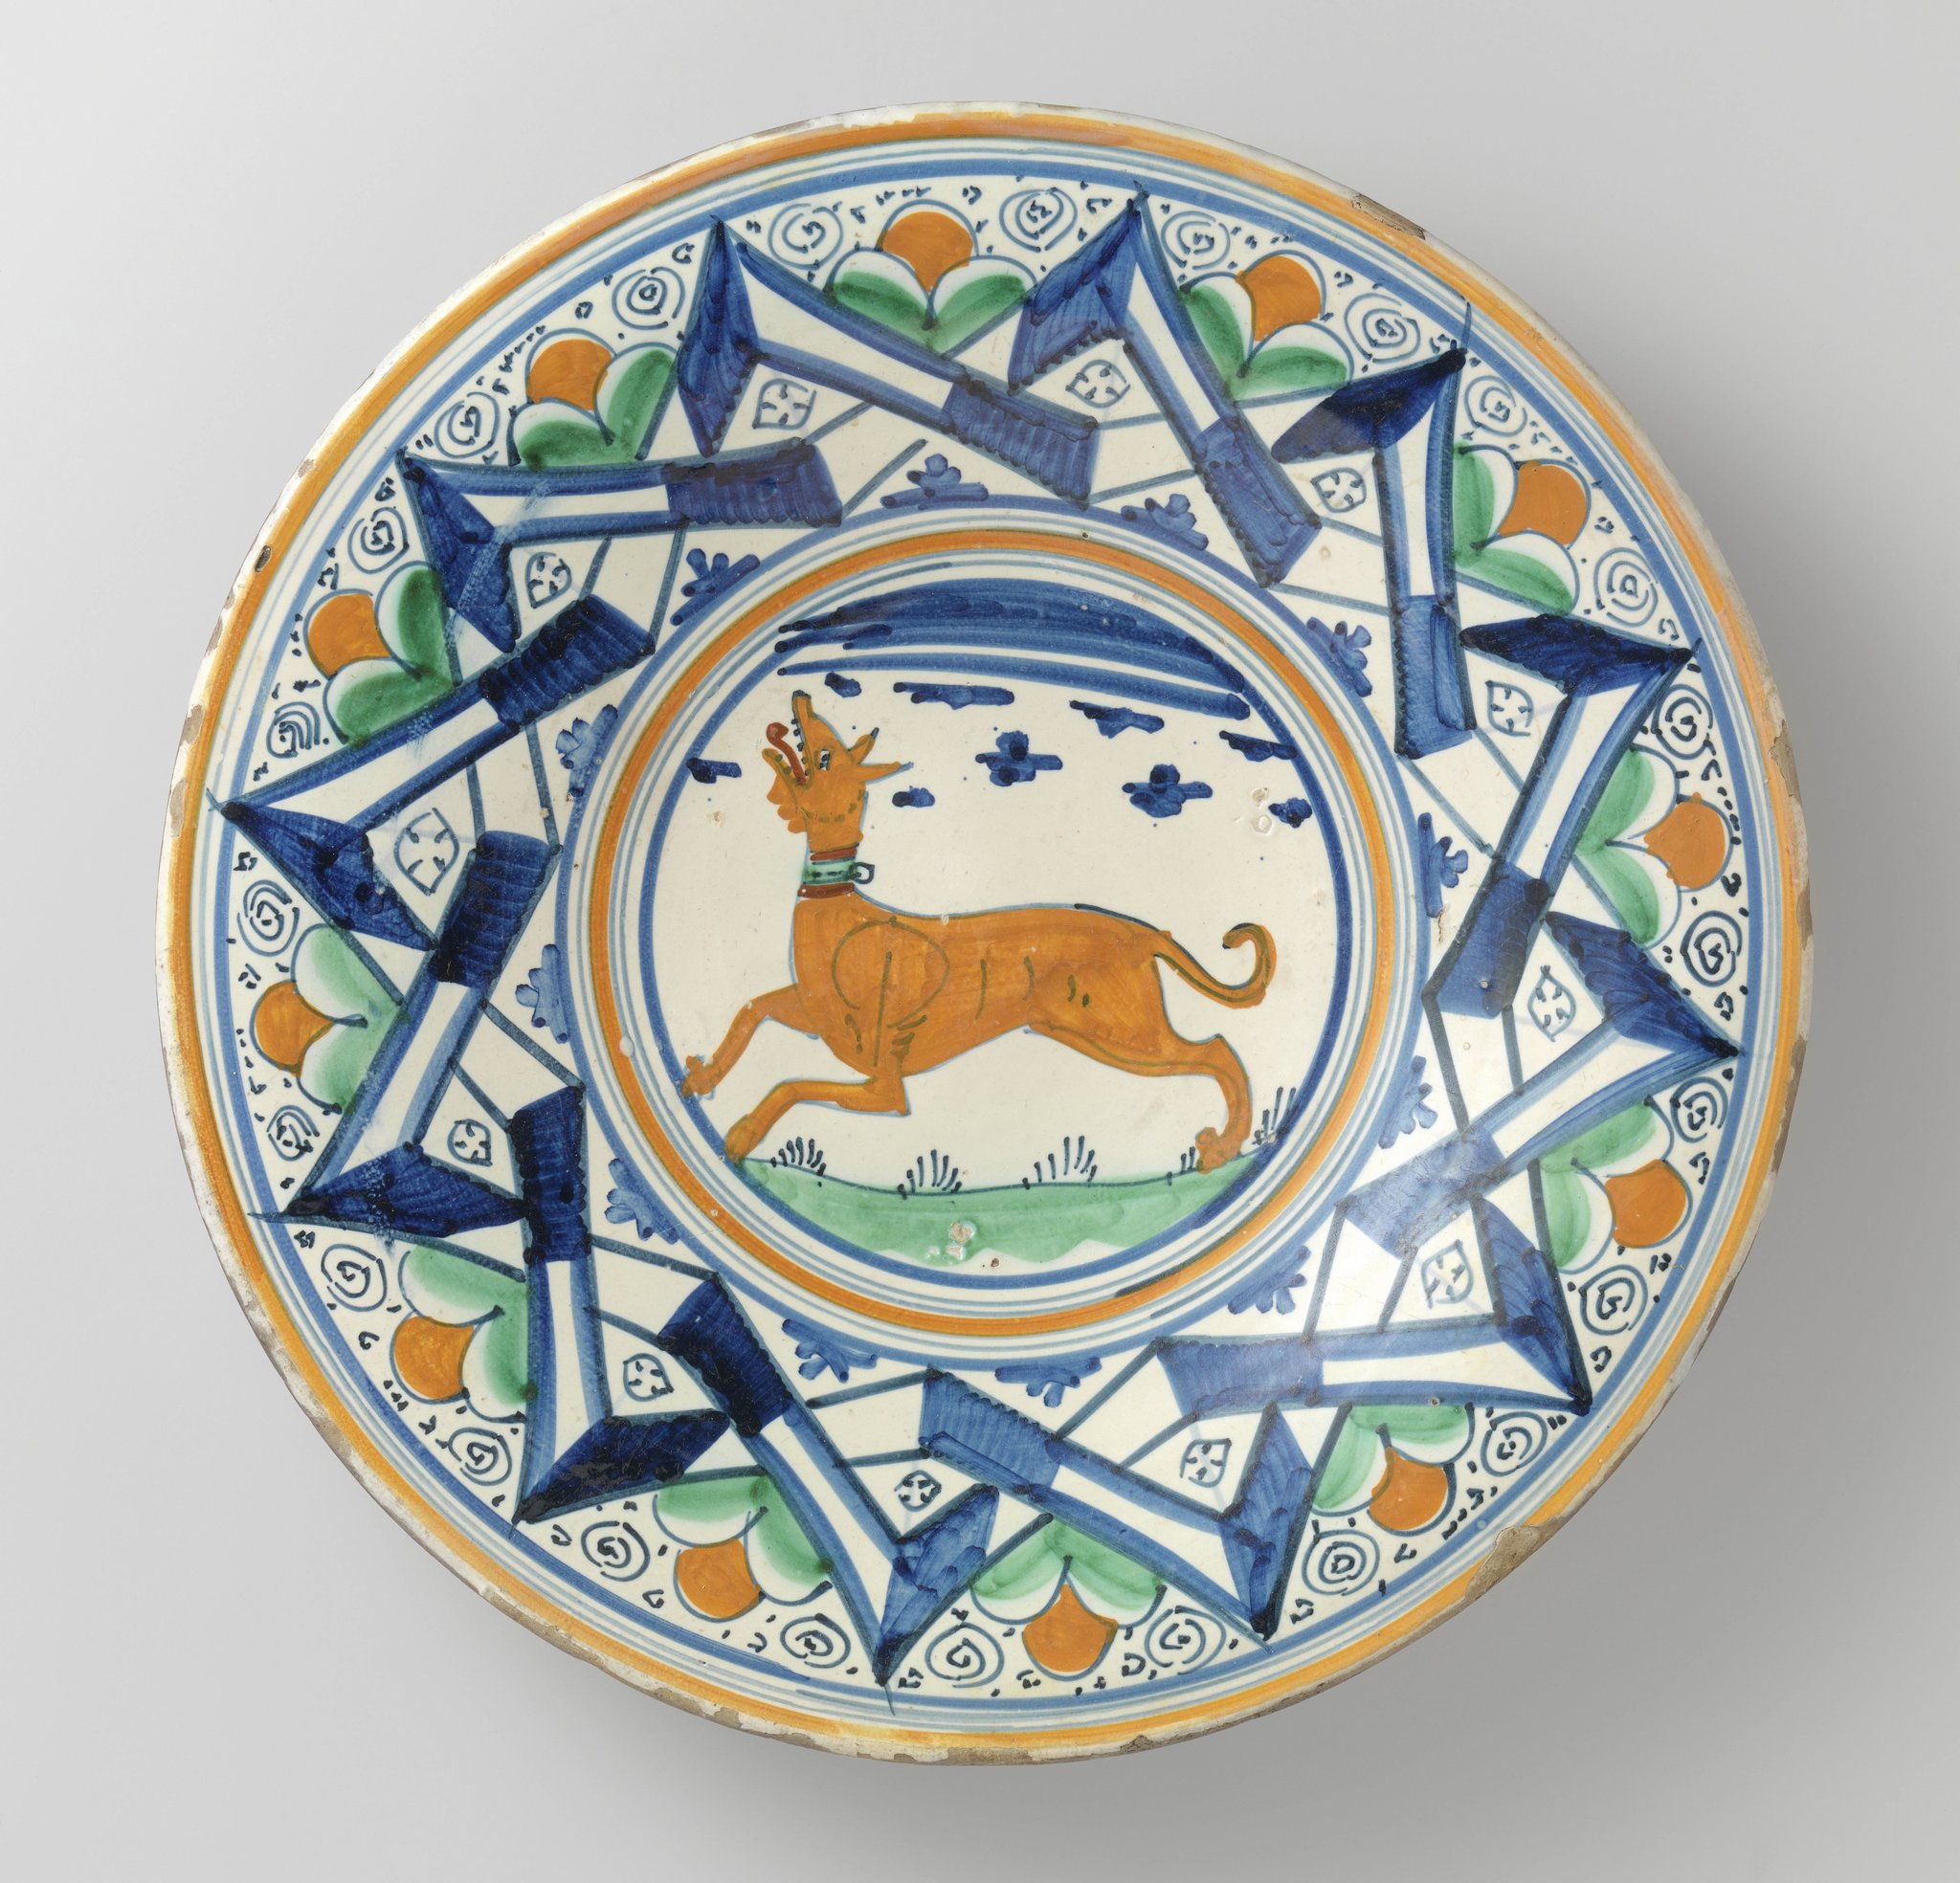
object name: platter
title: Schotel, veelkleurig beschilderd met op het plat een hond, omgeven door twee elkaar zigzaggende en elkaar kruisende lijnen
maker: Anonymous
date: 1520-1540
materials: earthenware, glaze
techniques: maiolica, painted, polychromy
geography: montelupo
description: Dish. Montelupo, c. 1520 - 1540.